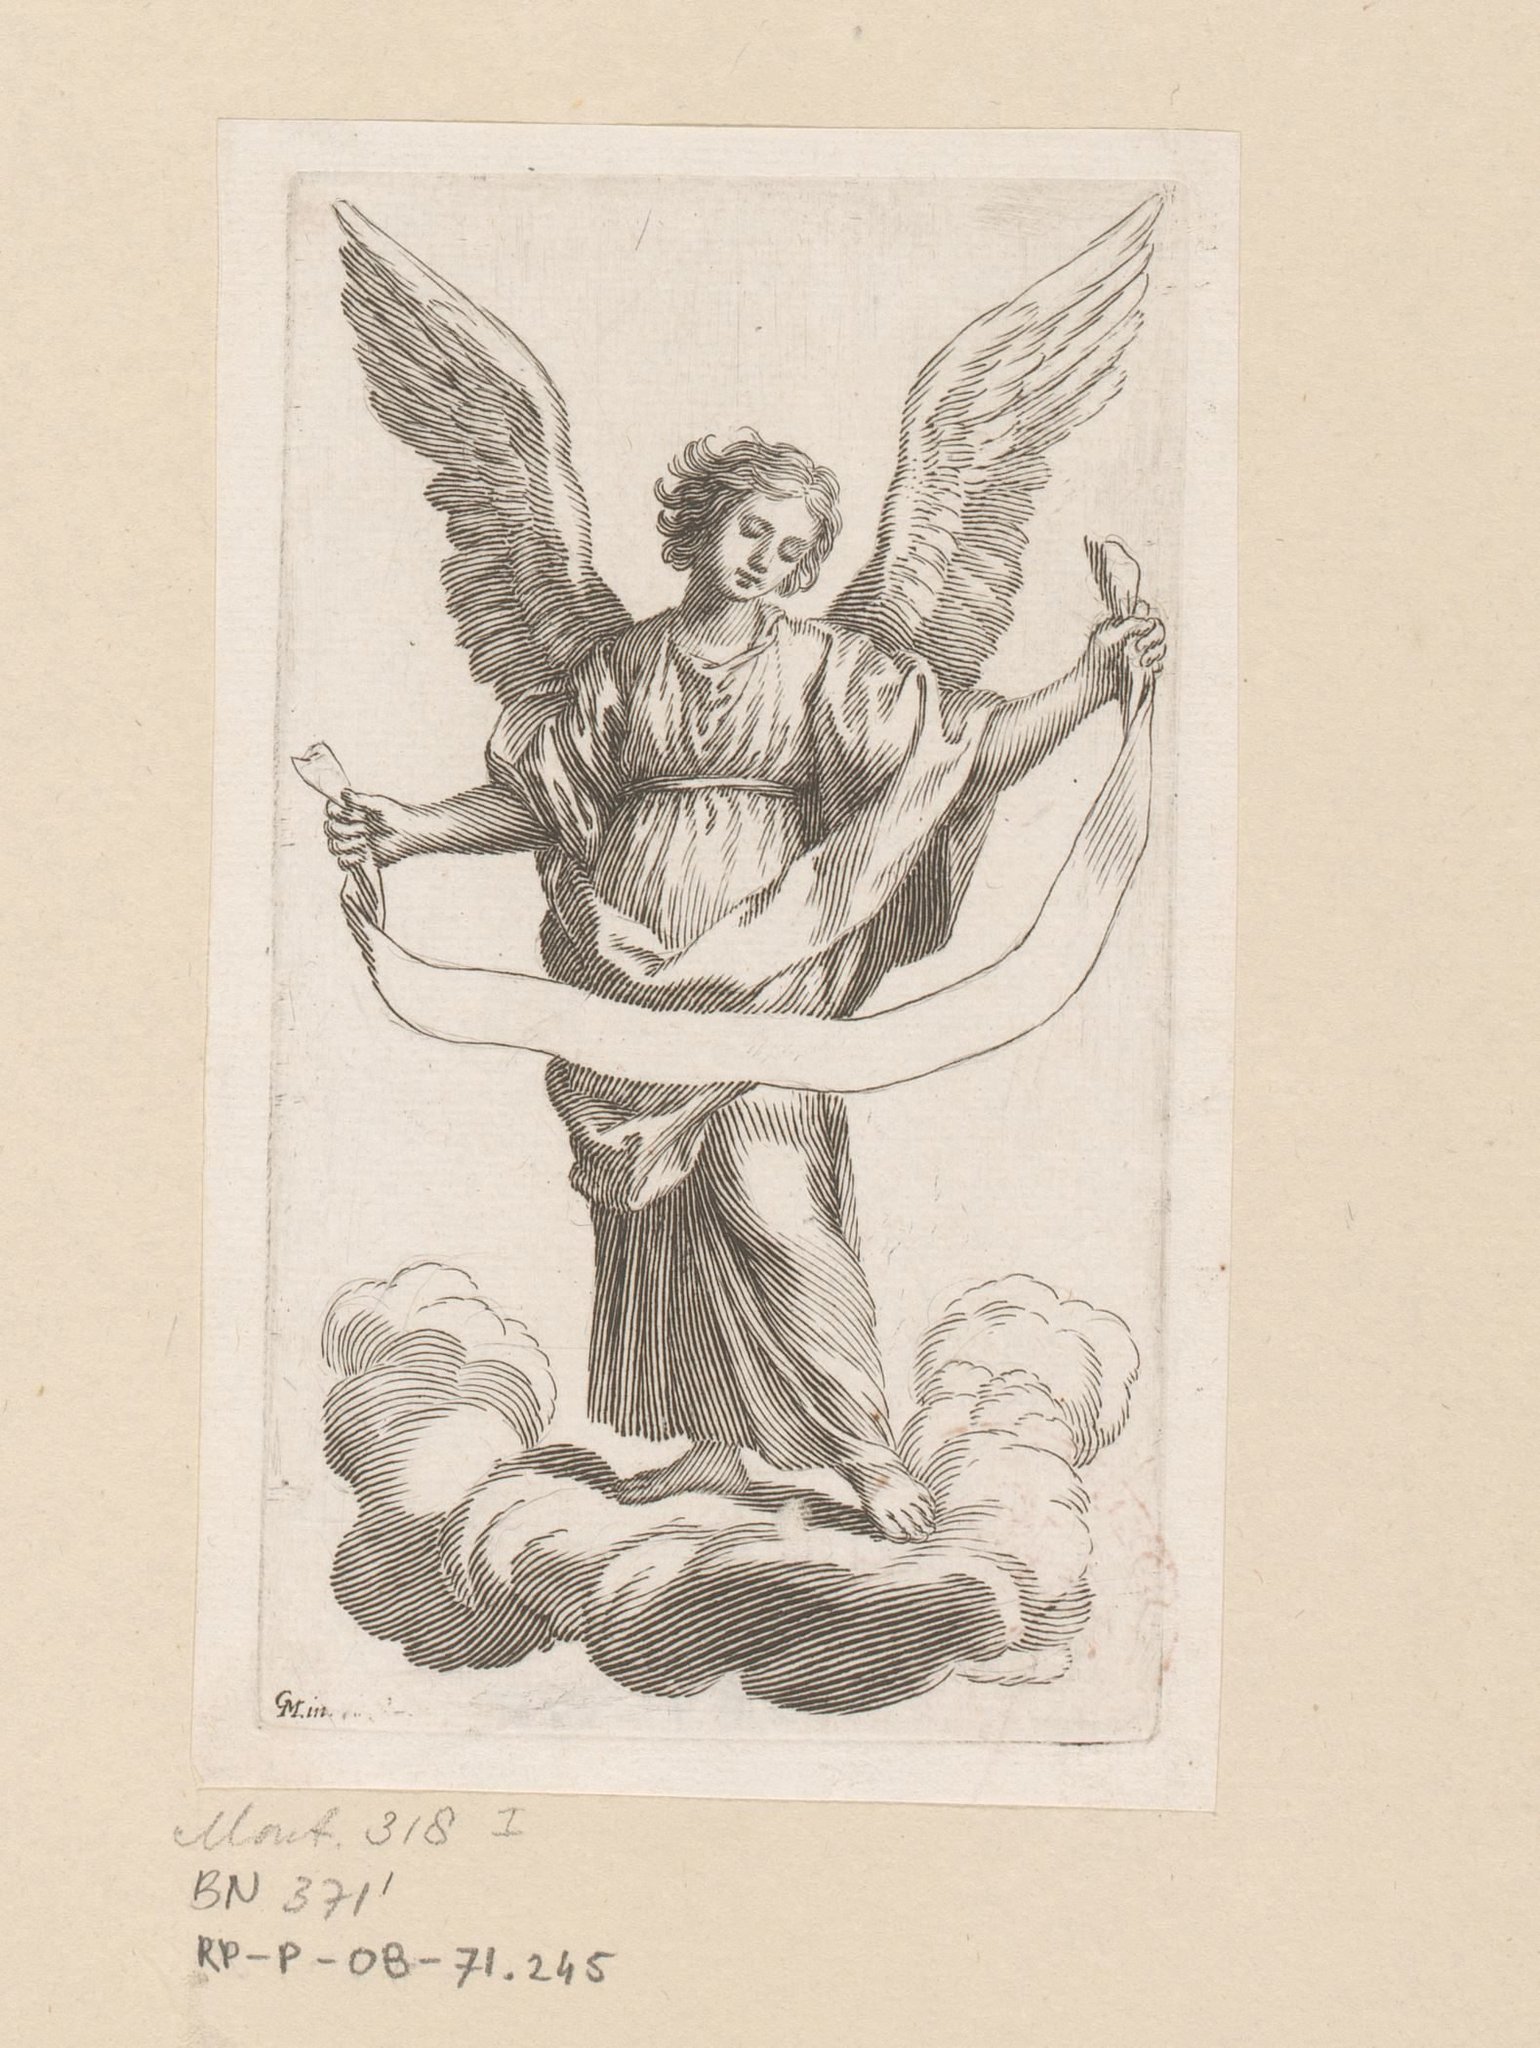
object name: titelblad, titelpagina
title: Engel staande op een wolk met banderol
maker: claude mellan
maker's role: draughtsman, print maker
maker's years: 1598-1688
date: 1608-1688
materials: paper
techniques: engraving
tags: angels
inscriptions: collector's mark: Lugt 240